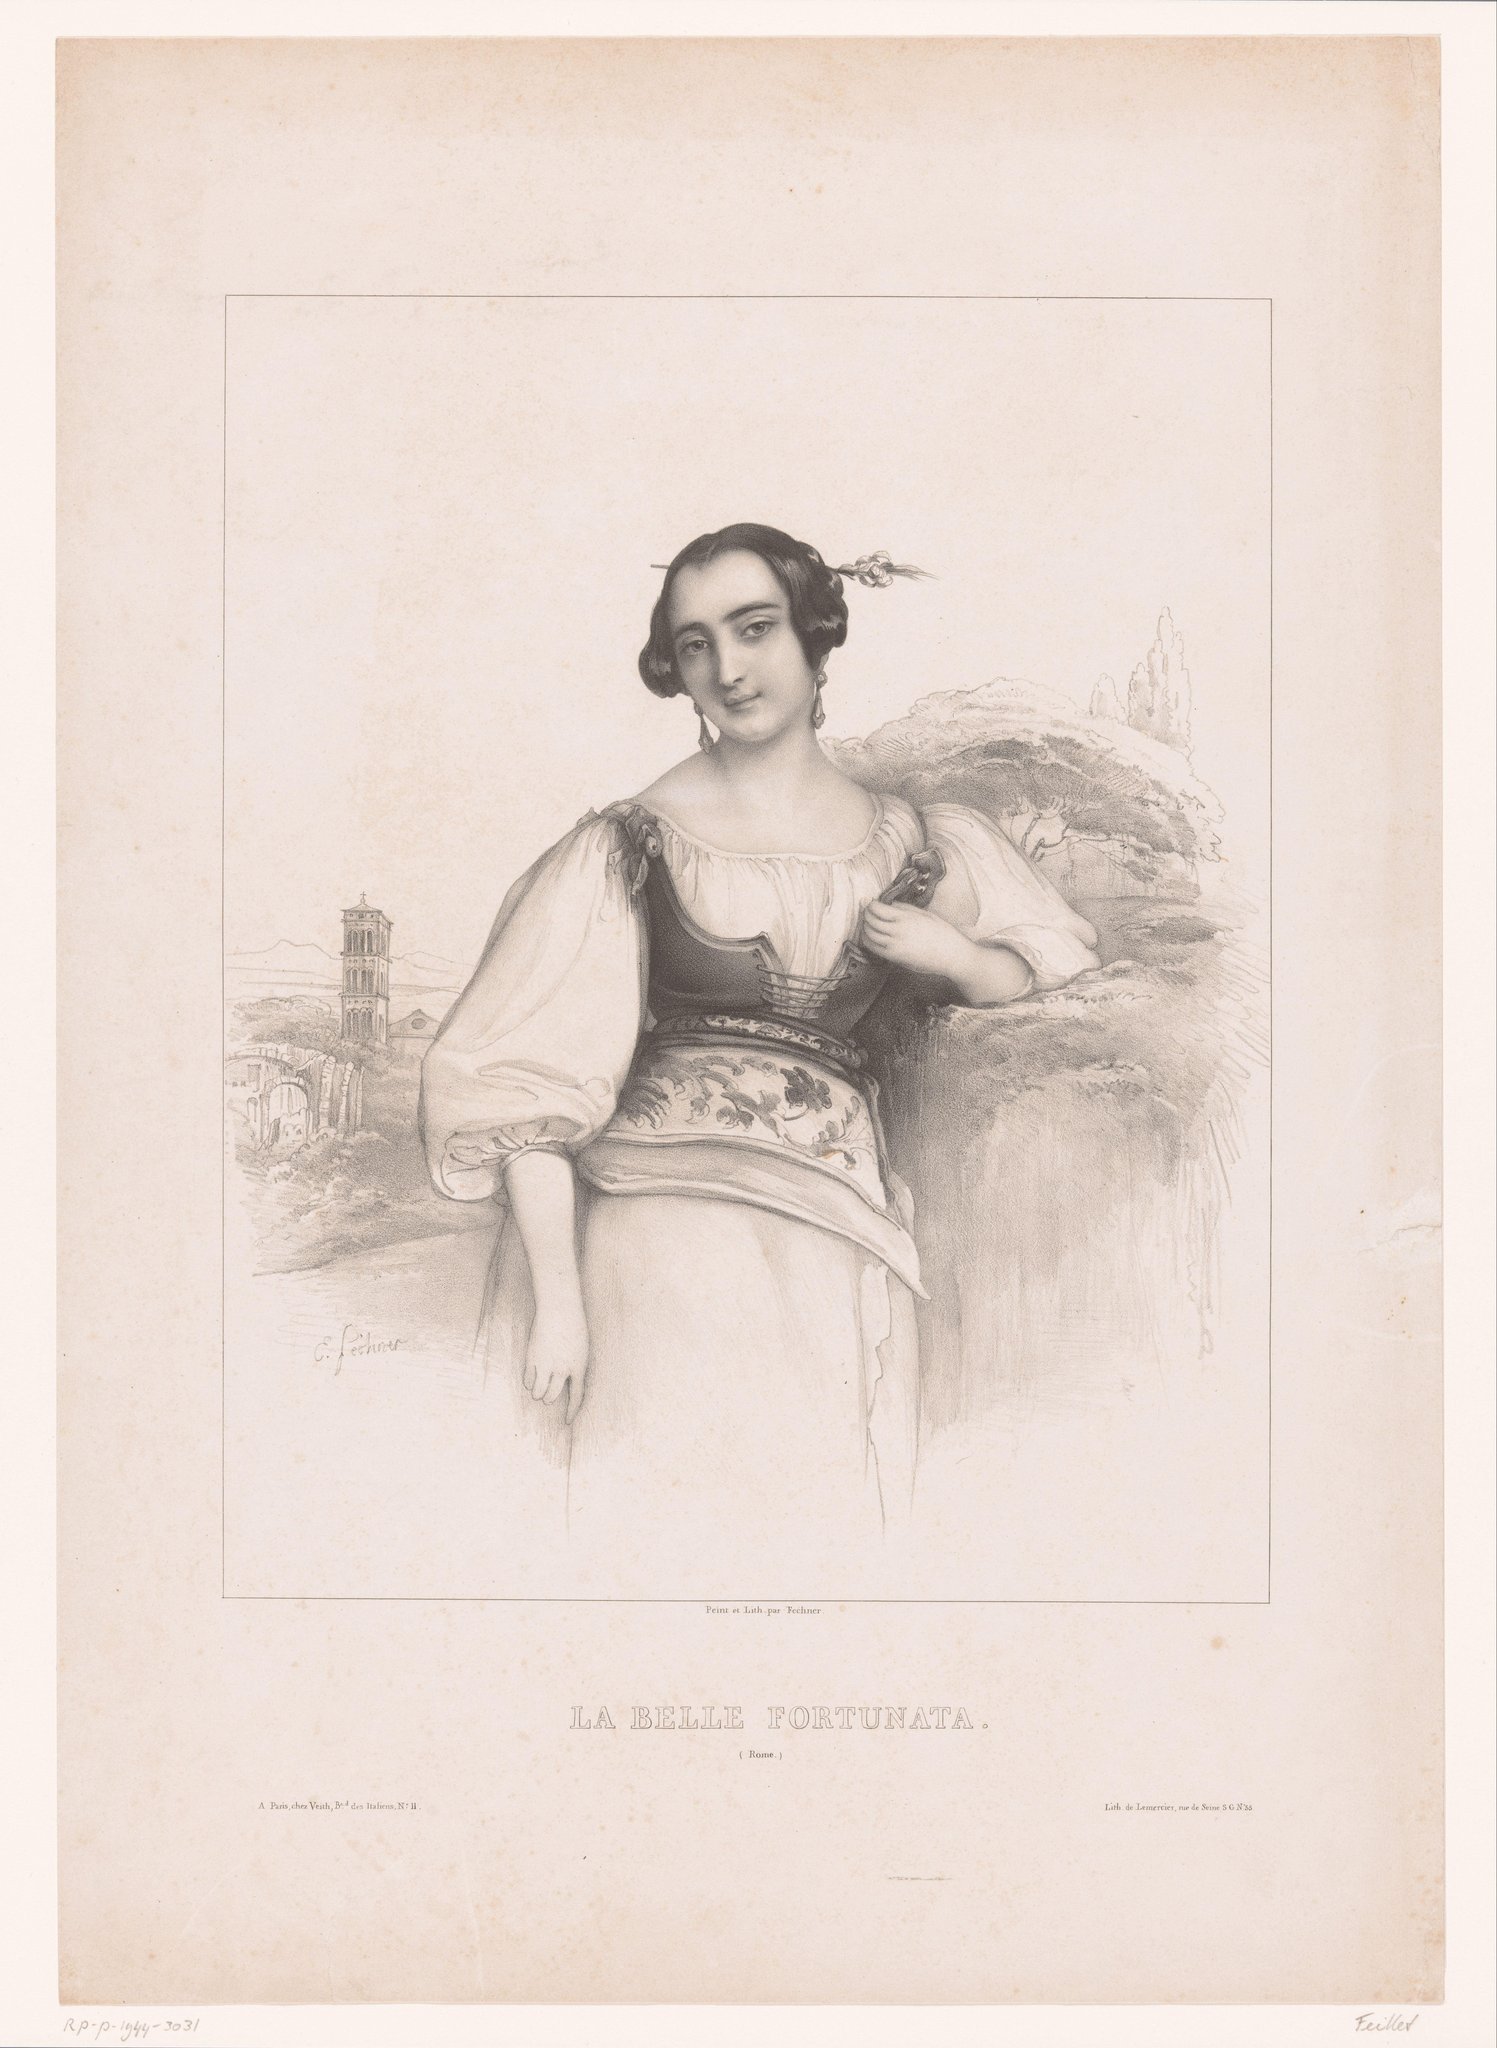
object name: print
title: La belle Fortunata (Rome)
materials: paper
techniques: lithograph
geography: paris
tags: adolescent, young woman, maiden, folk costume, regional costume, europeans (with name), rome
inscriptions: collector's mark: Lugt 2228a